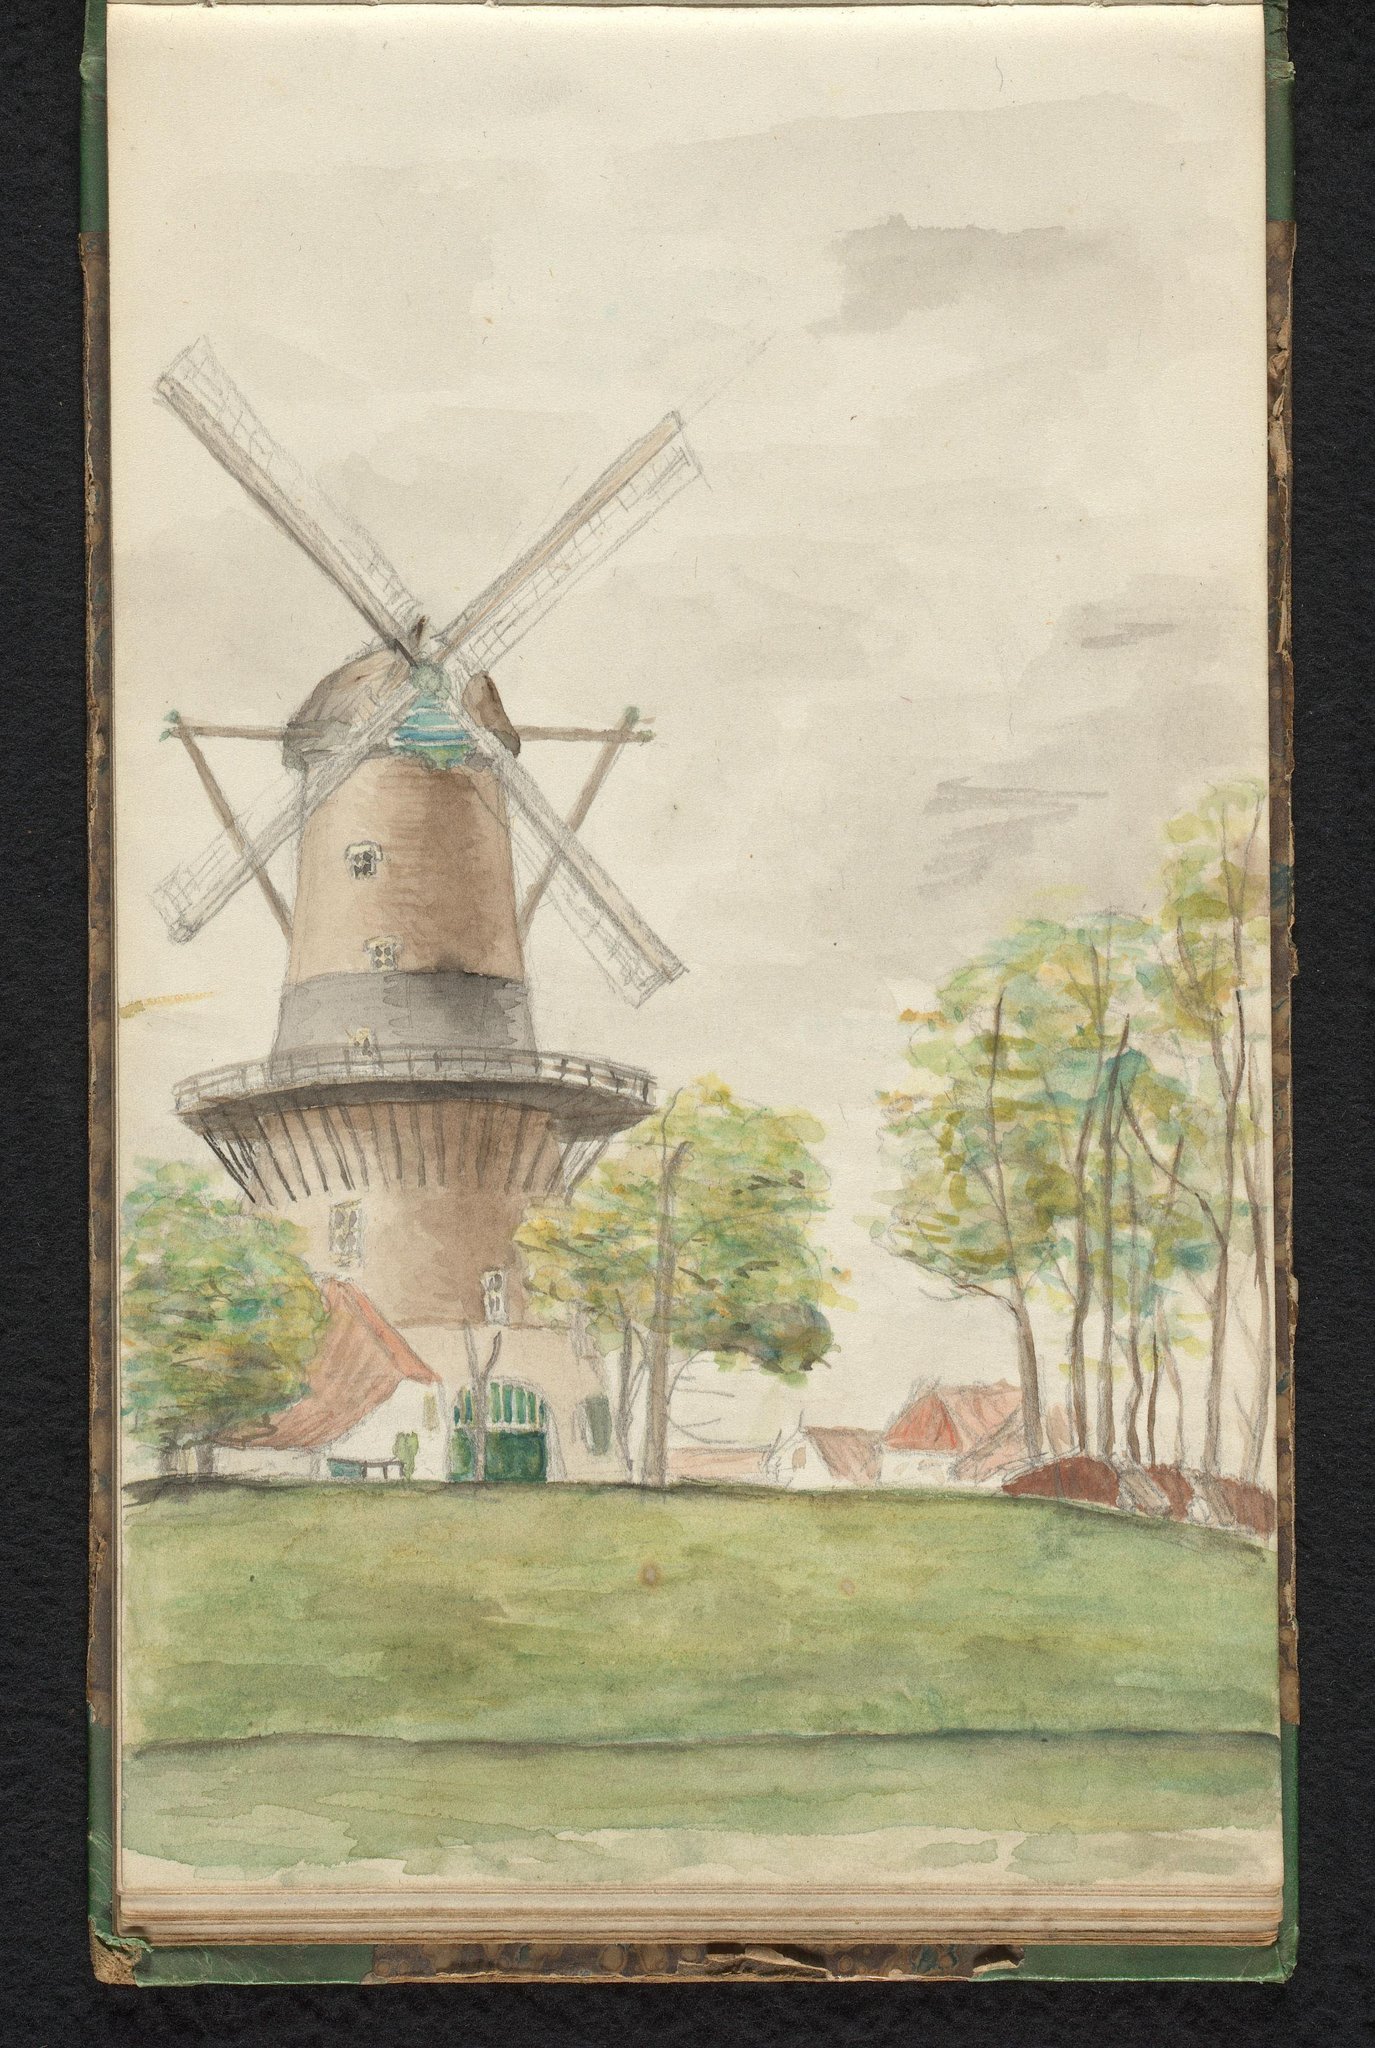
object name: sketchbook leaf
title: Landschap met molen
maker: jan bedijs tom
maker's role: draughtsman, painter, print maker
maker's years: 1813-1894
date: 1823-1894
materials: paper, pencil, watercolor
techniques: brush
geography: the hague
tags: windmill in landscape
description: Pagina 15 verso uit een schetsboek met 61 bladen.